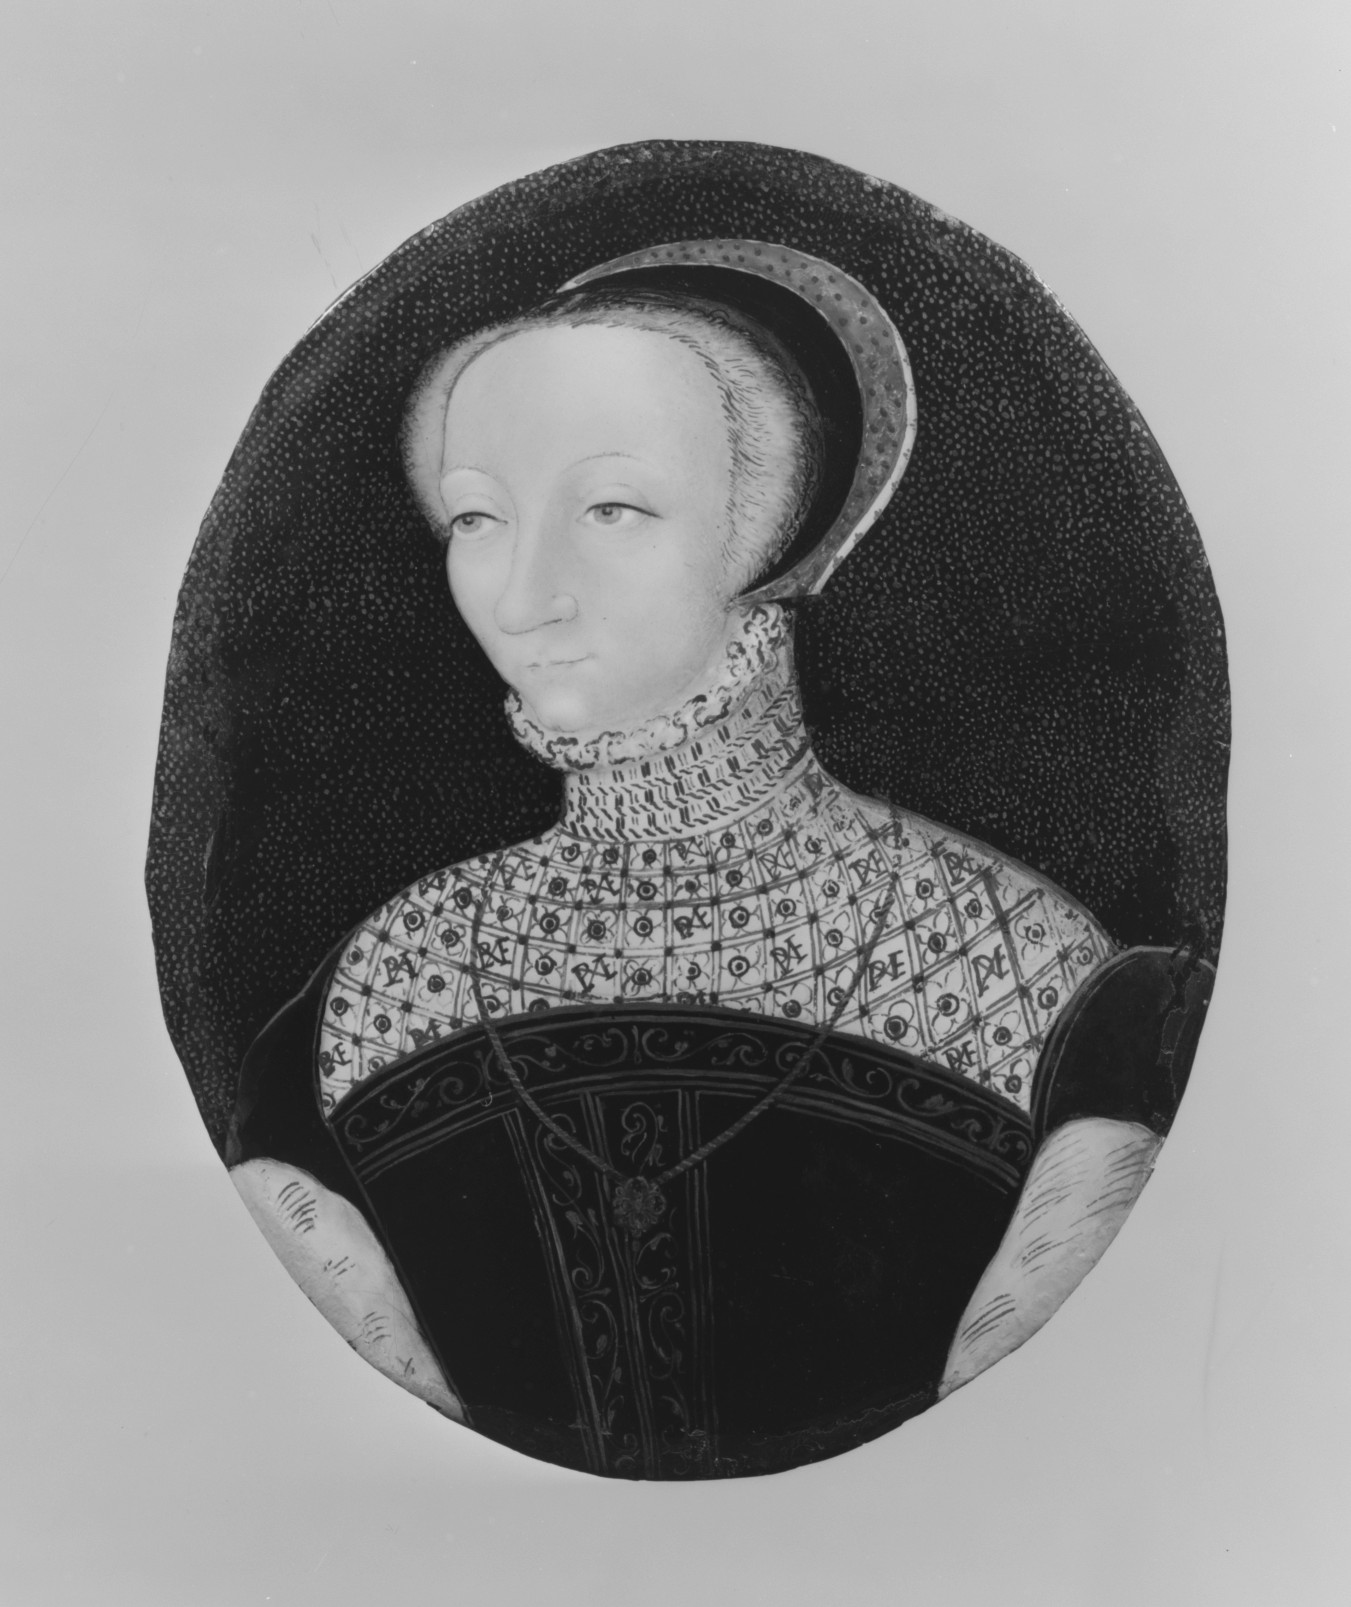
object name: plaque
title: Portrait of Jeanne de Genouillac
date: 1801-1850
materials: copper, enamel, gilt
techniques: painting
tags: portraits,women